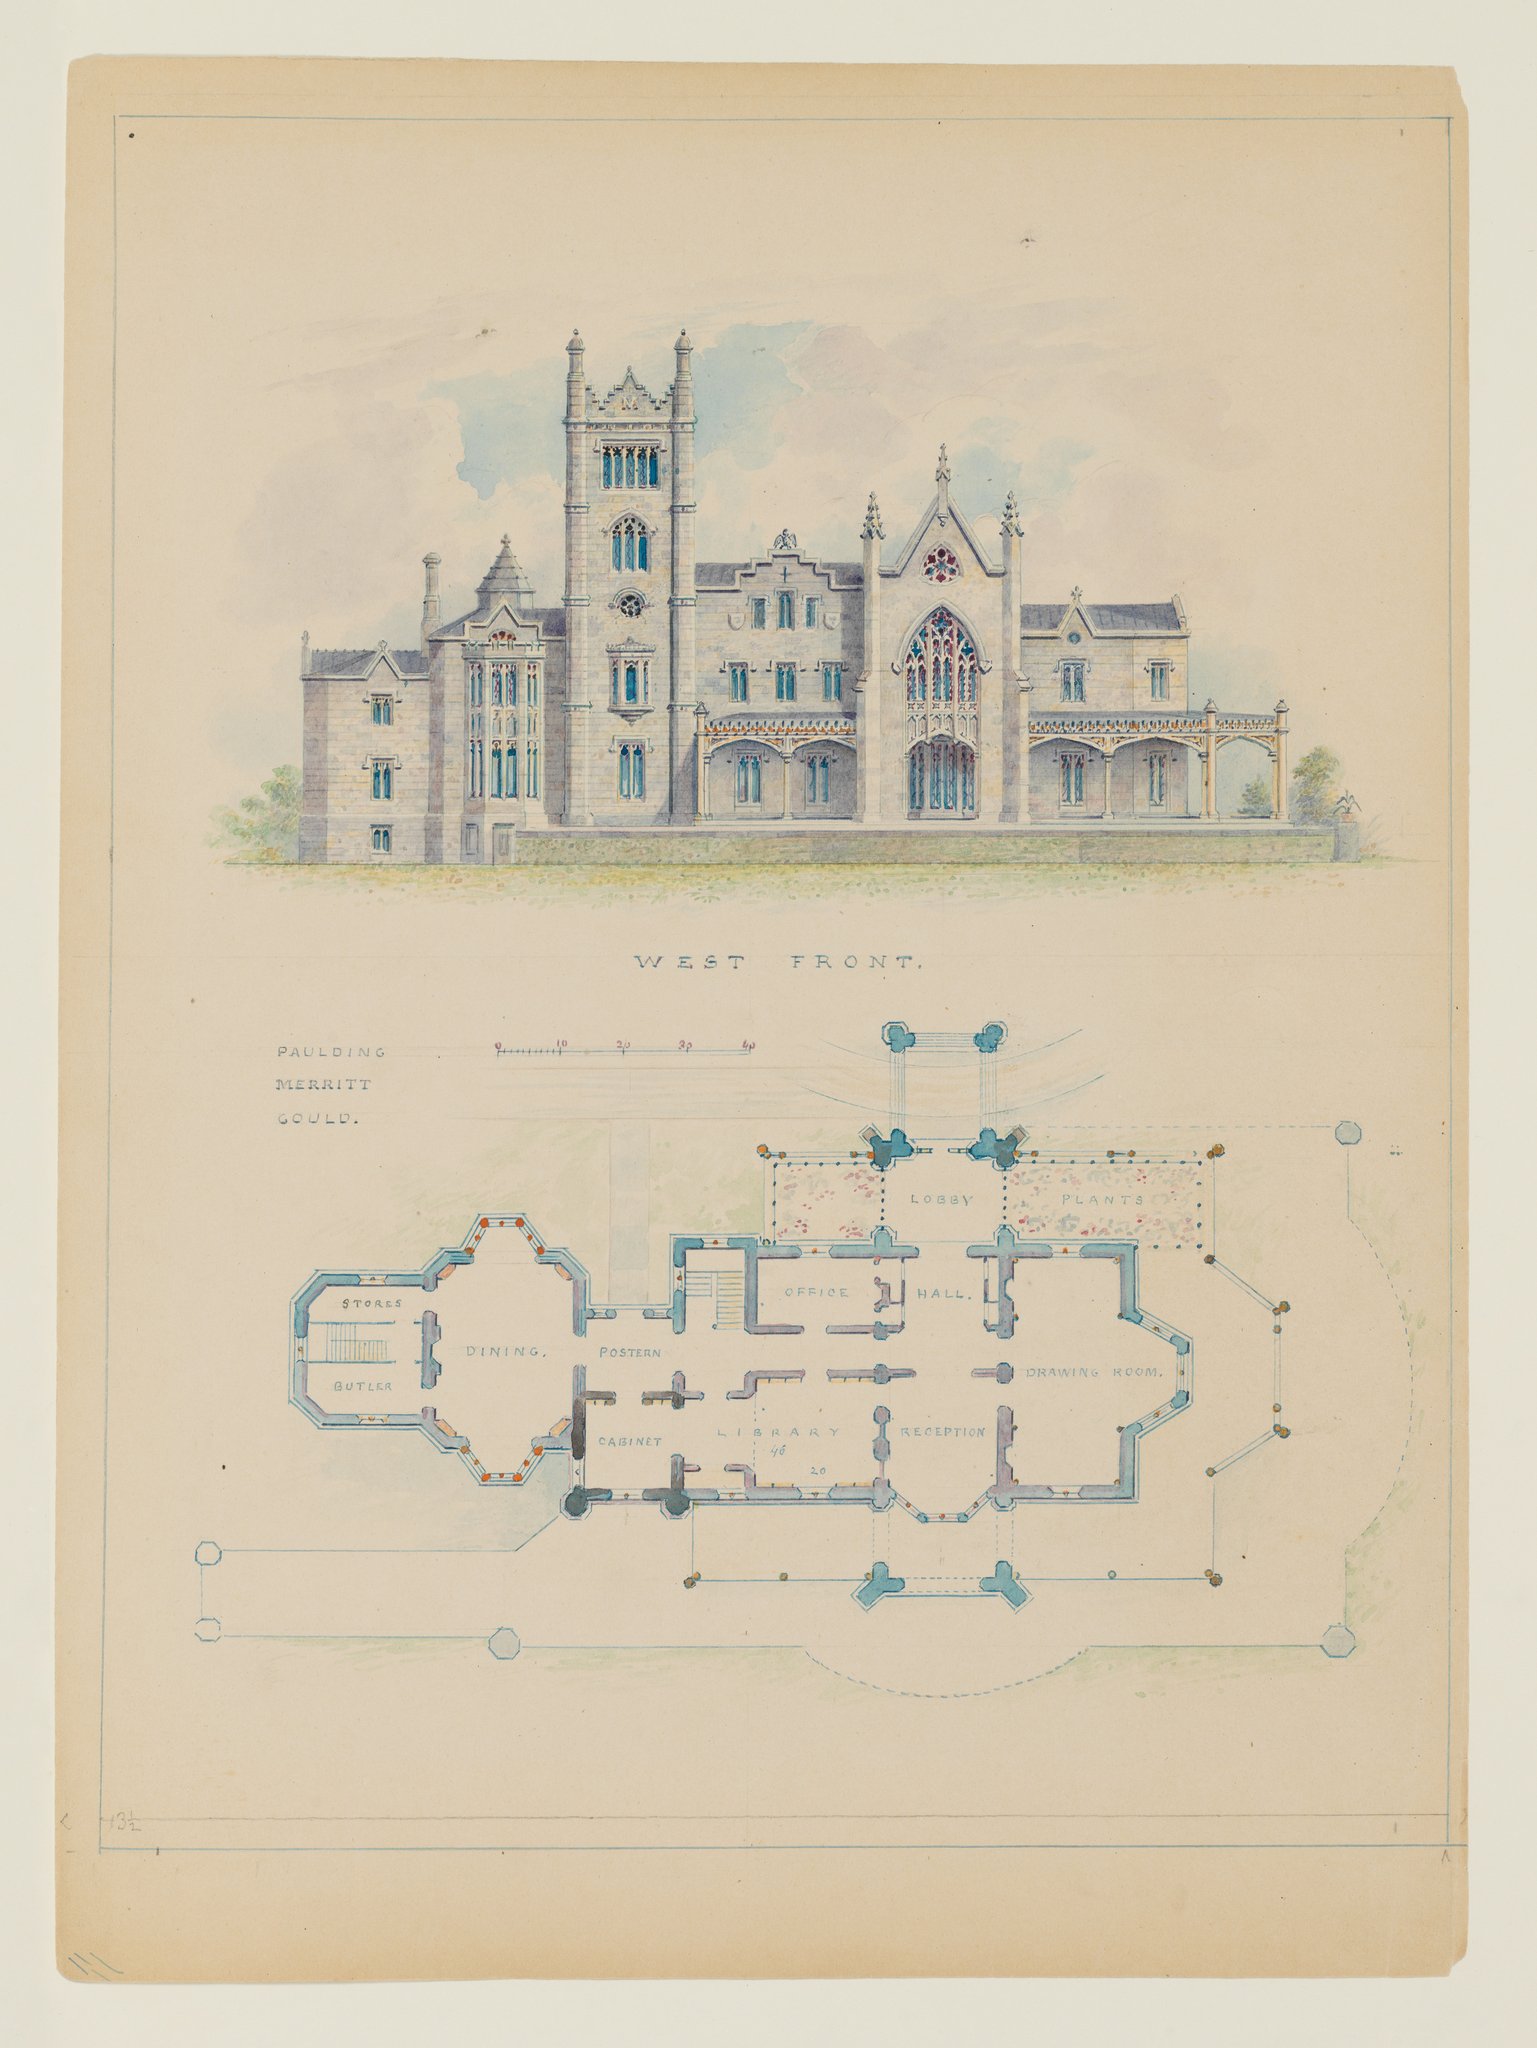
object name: drawing ornament architecture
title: Floorplan and Elevation of the West Front of Lyndhurst, also known as Knoll (Tarrytown)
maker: alexander jackson davis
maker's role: artist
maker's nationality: american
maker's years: 1803-1892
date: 1880-1892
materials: graphite, ink, watercolor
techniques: pen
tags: architecture,houses